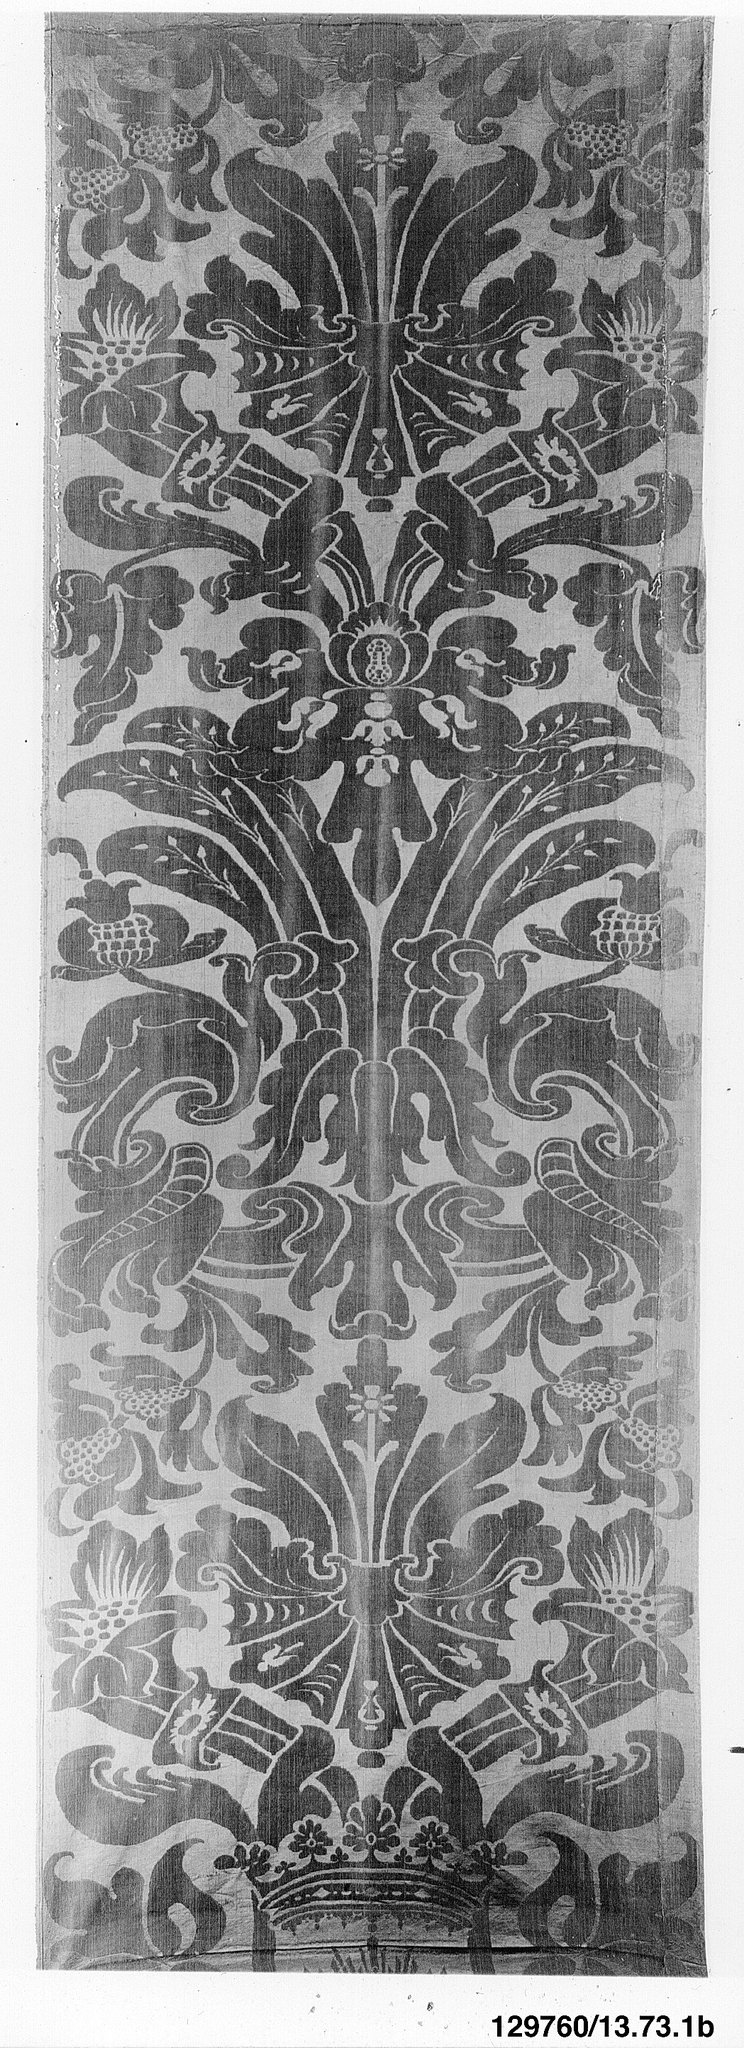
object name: piece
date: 1601-1700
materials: silk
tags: flowers,leaves